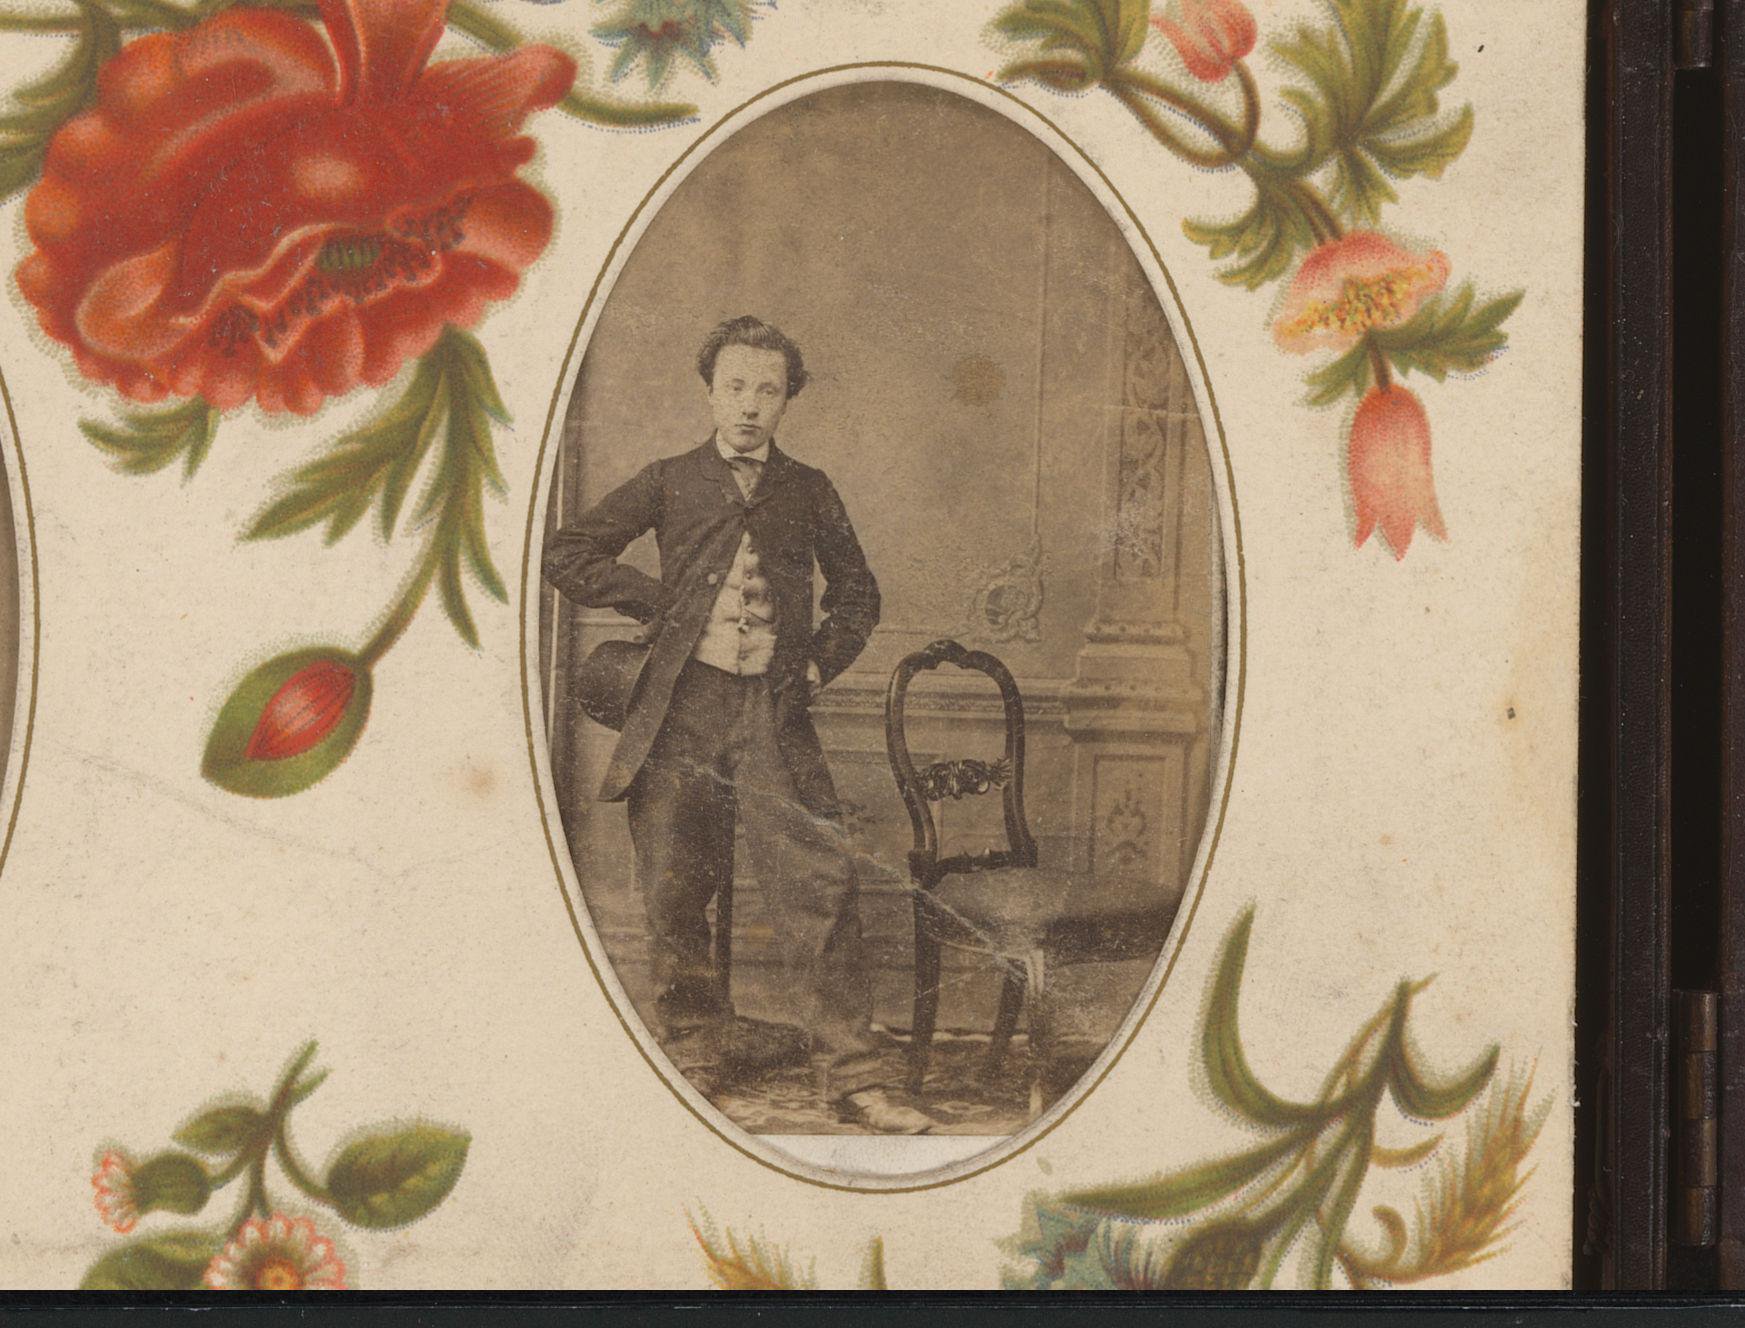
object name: album leaf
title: Portret van een staande jongen met hoed in de hand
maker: Anonymous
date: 1860-1900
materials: cardboard, photographic support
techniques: albumen print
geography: england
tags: boy (child between toddler and youth), historical persons, head-gear: hat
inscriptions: name: ‘RBla[k]eb[..]’